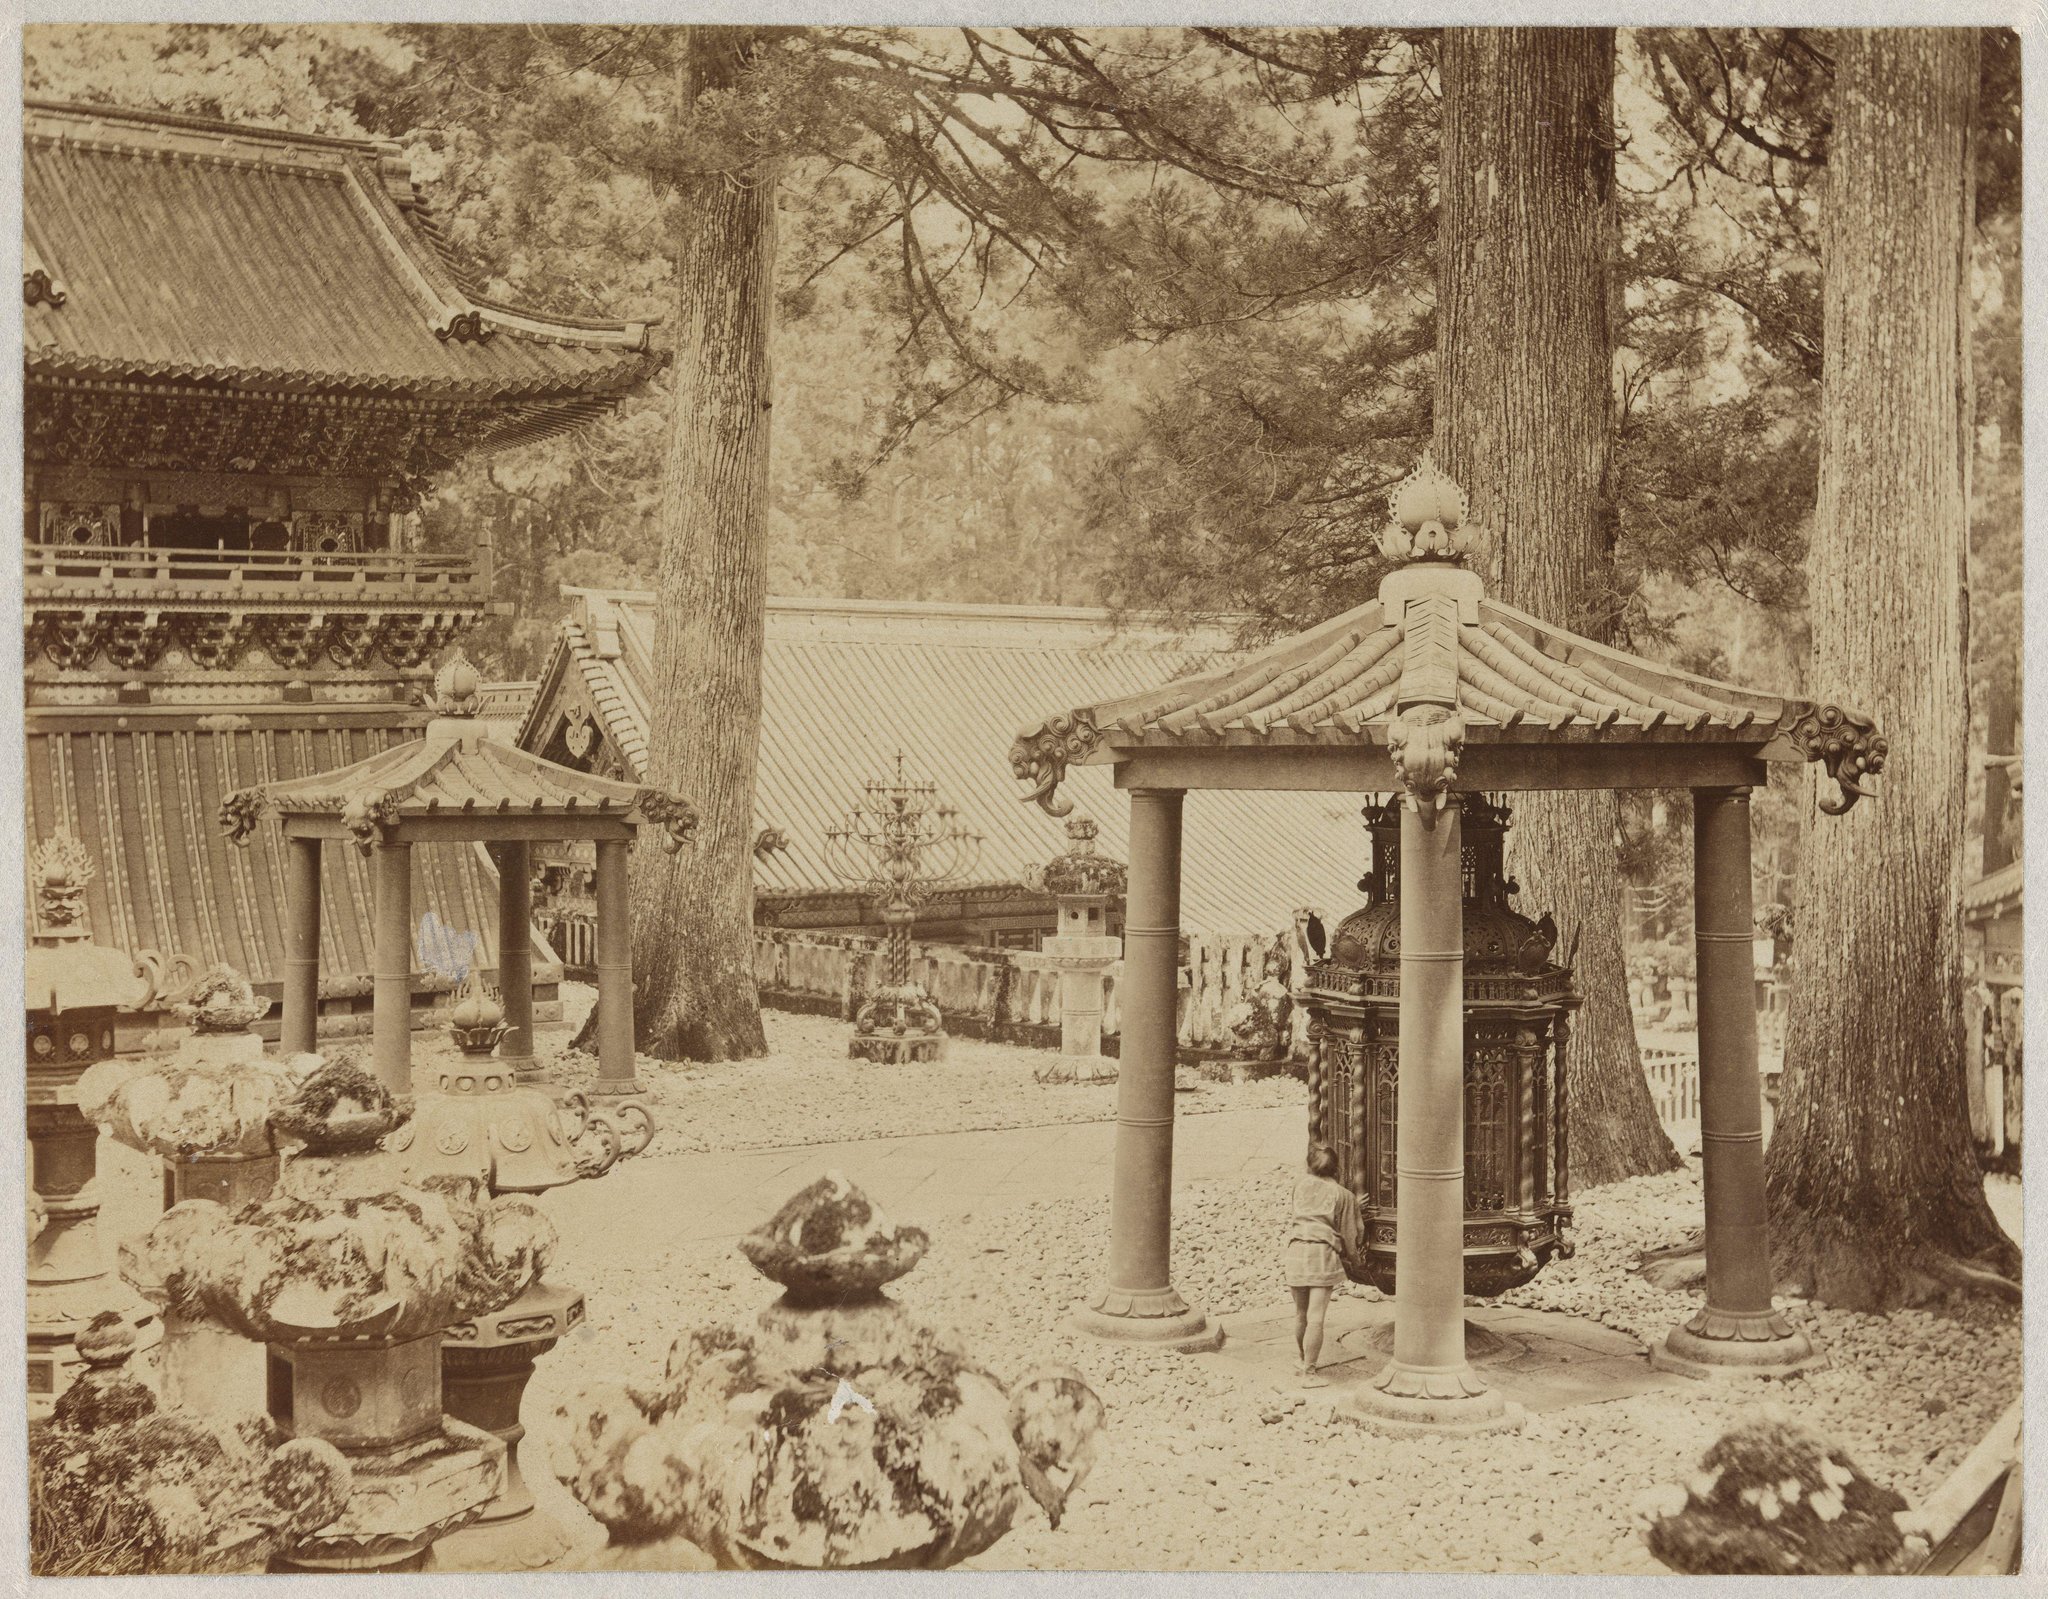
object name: photograph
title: Tempel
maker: Anonymous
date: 1865-1875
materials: paper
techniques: albumen print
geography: japan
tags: japan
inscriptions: number: ‘F5’, number: ‘BL13’, number: ‘BD161’